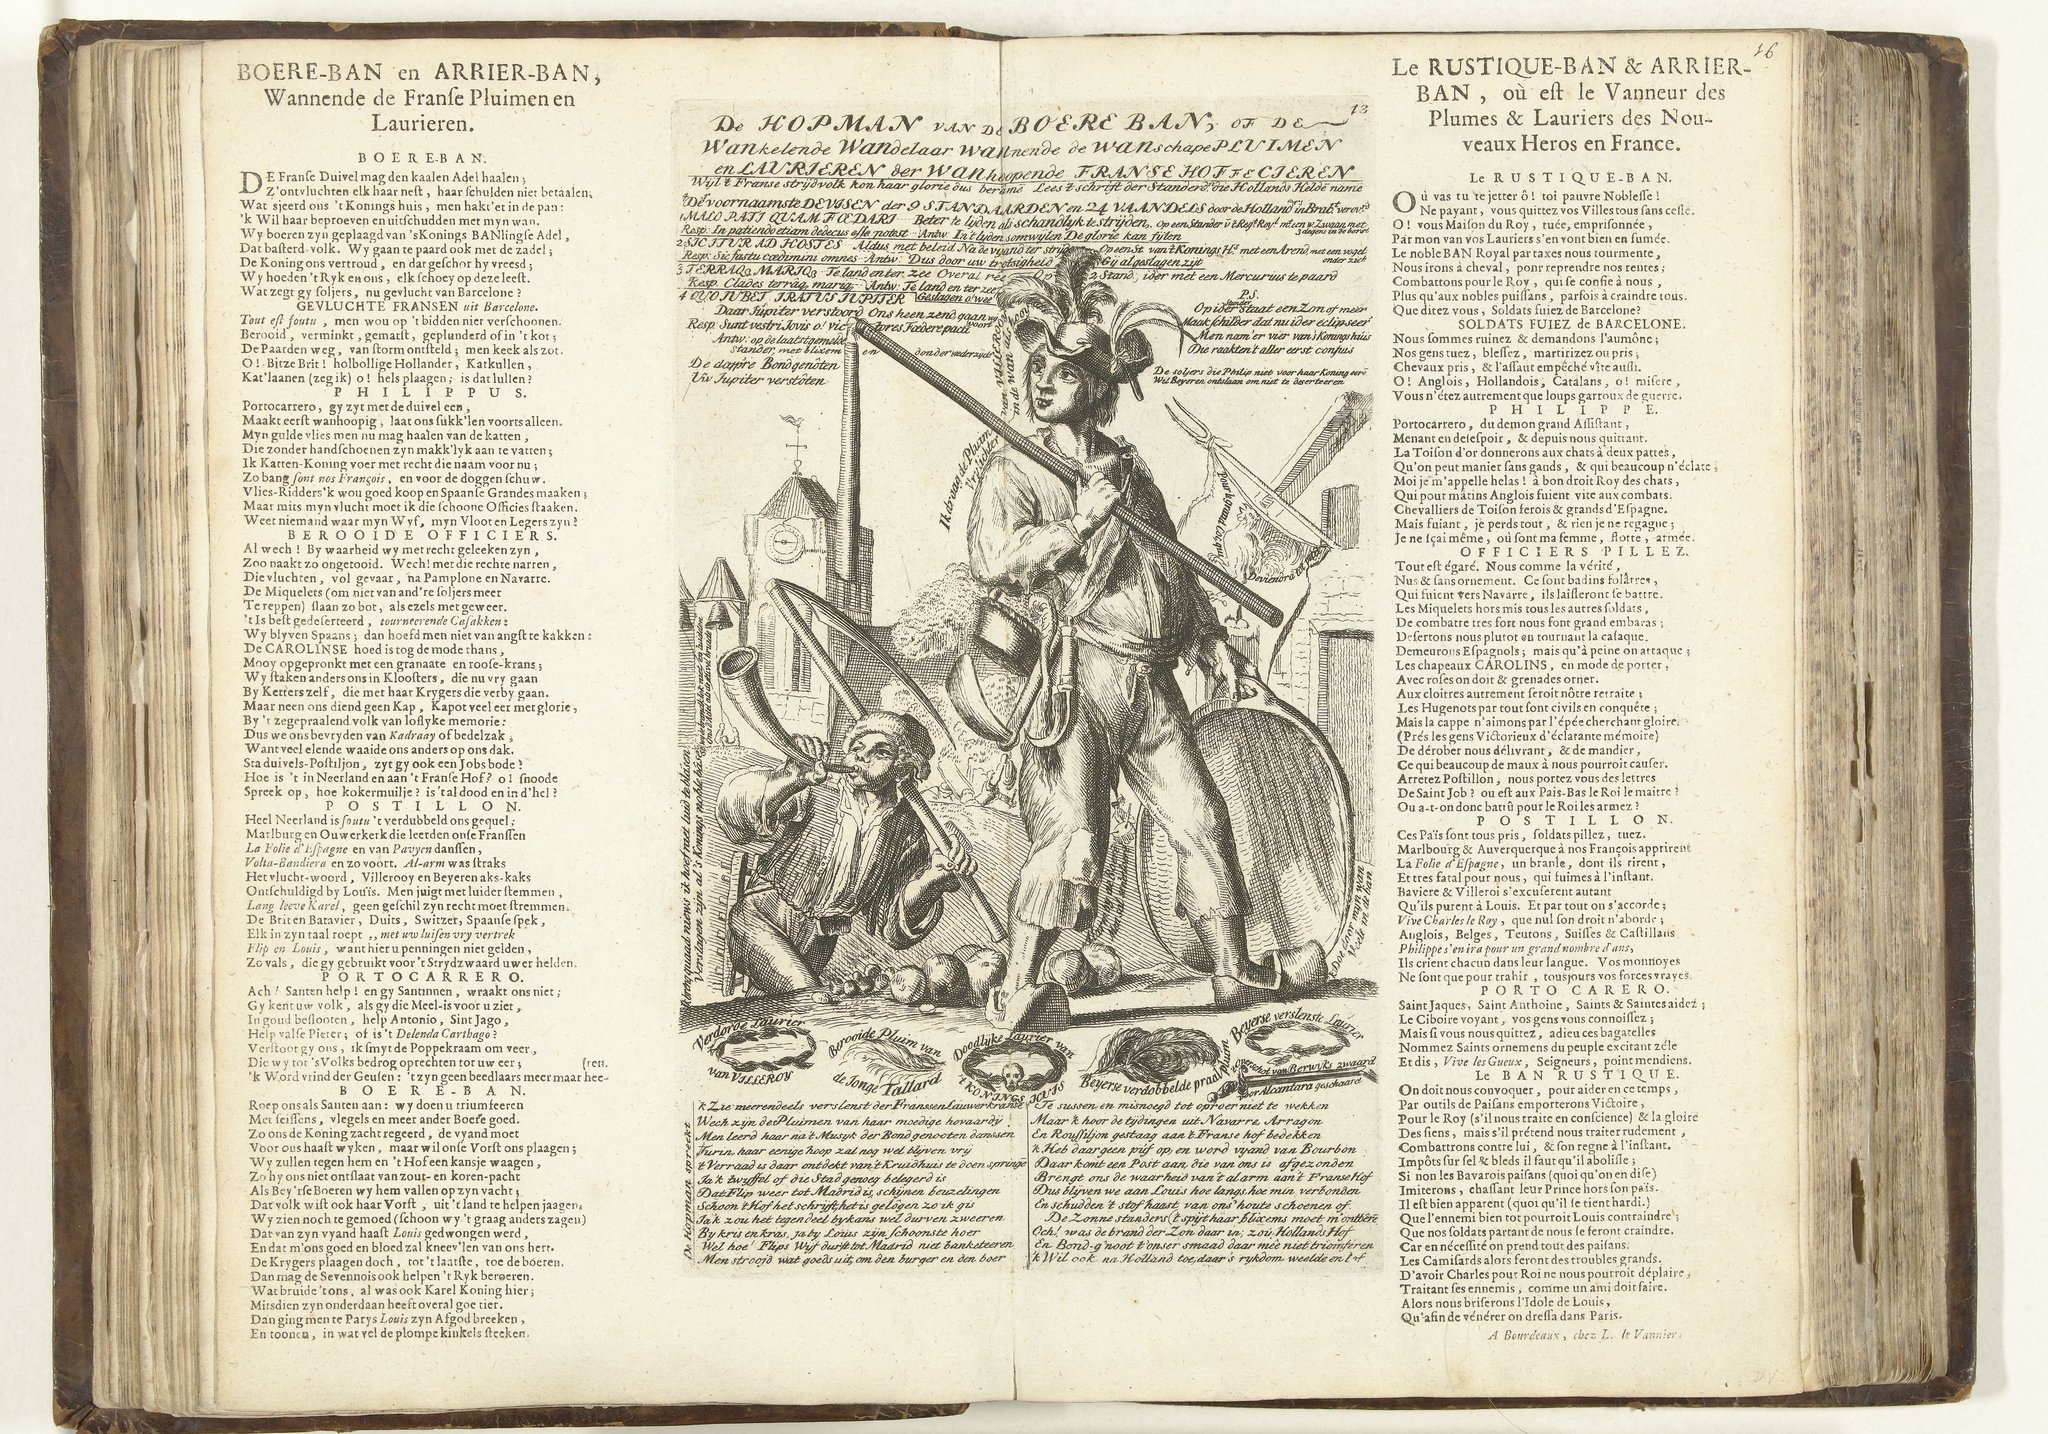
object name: print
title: Boere-Ban en Arrier-Ban, Wannende de Franse Pluimen en Laurieren / Le Rustique-Ban & Arrier-Ban, où est le Vanneur des Plumes & Lauriers des Nouveaux Heros en France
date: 1706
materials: paper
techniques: etching, letterpress printing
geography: amsterdam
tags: farmers, political caricatures and satires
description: Spotprent op de Franse boerensoldaten die als het op vechten aankomt vluchten naar het kakhuis. Staande Franse boer met vlegel en wan, achter hem blaast een boer met een zeis op een hoorn. In de plaat verzen en opschriften in het Nederlands, op het blad aan weerszijden van de plaat verzen in het Nederlands en Frans. Blad nr. 13 (genummerd rechtsboven) in de serie van 25 bladen getiteld: Byvoegsel tot de Koninglyke Almanach, genaamd het Gulde-Jaar der Bondgenooten, 1706. Onderdeel van het prentwerk uitgegeven onder de verzameltitel: 't Lust-Hof van Momus, met de gebundelde series van spotprenten tijdens de jaren 1701-1713 van de Spaanse Successieoorlog.